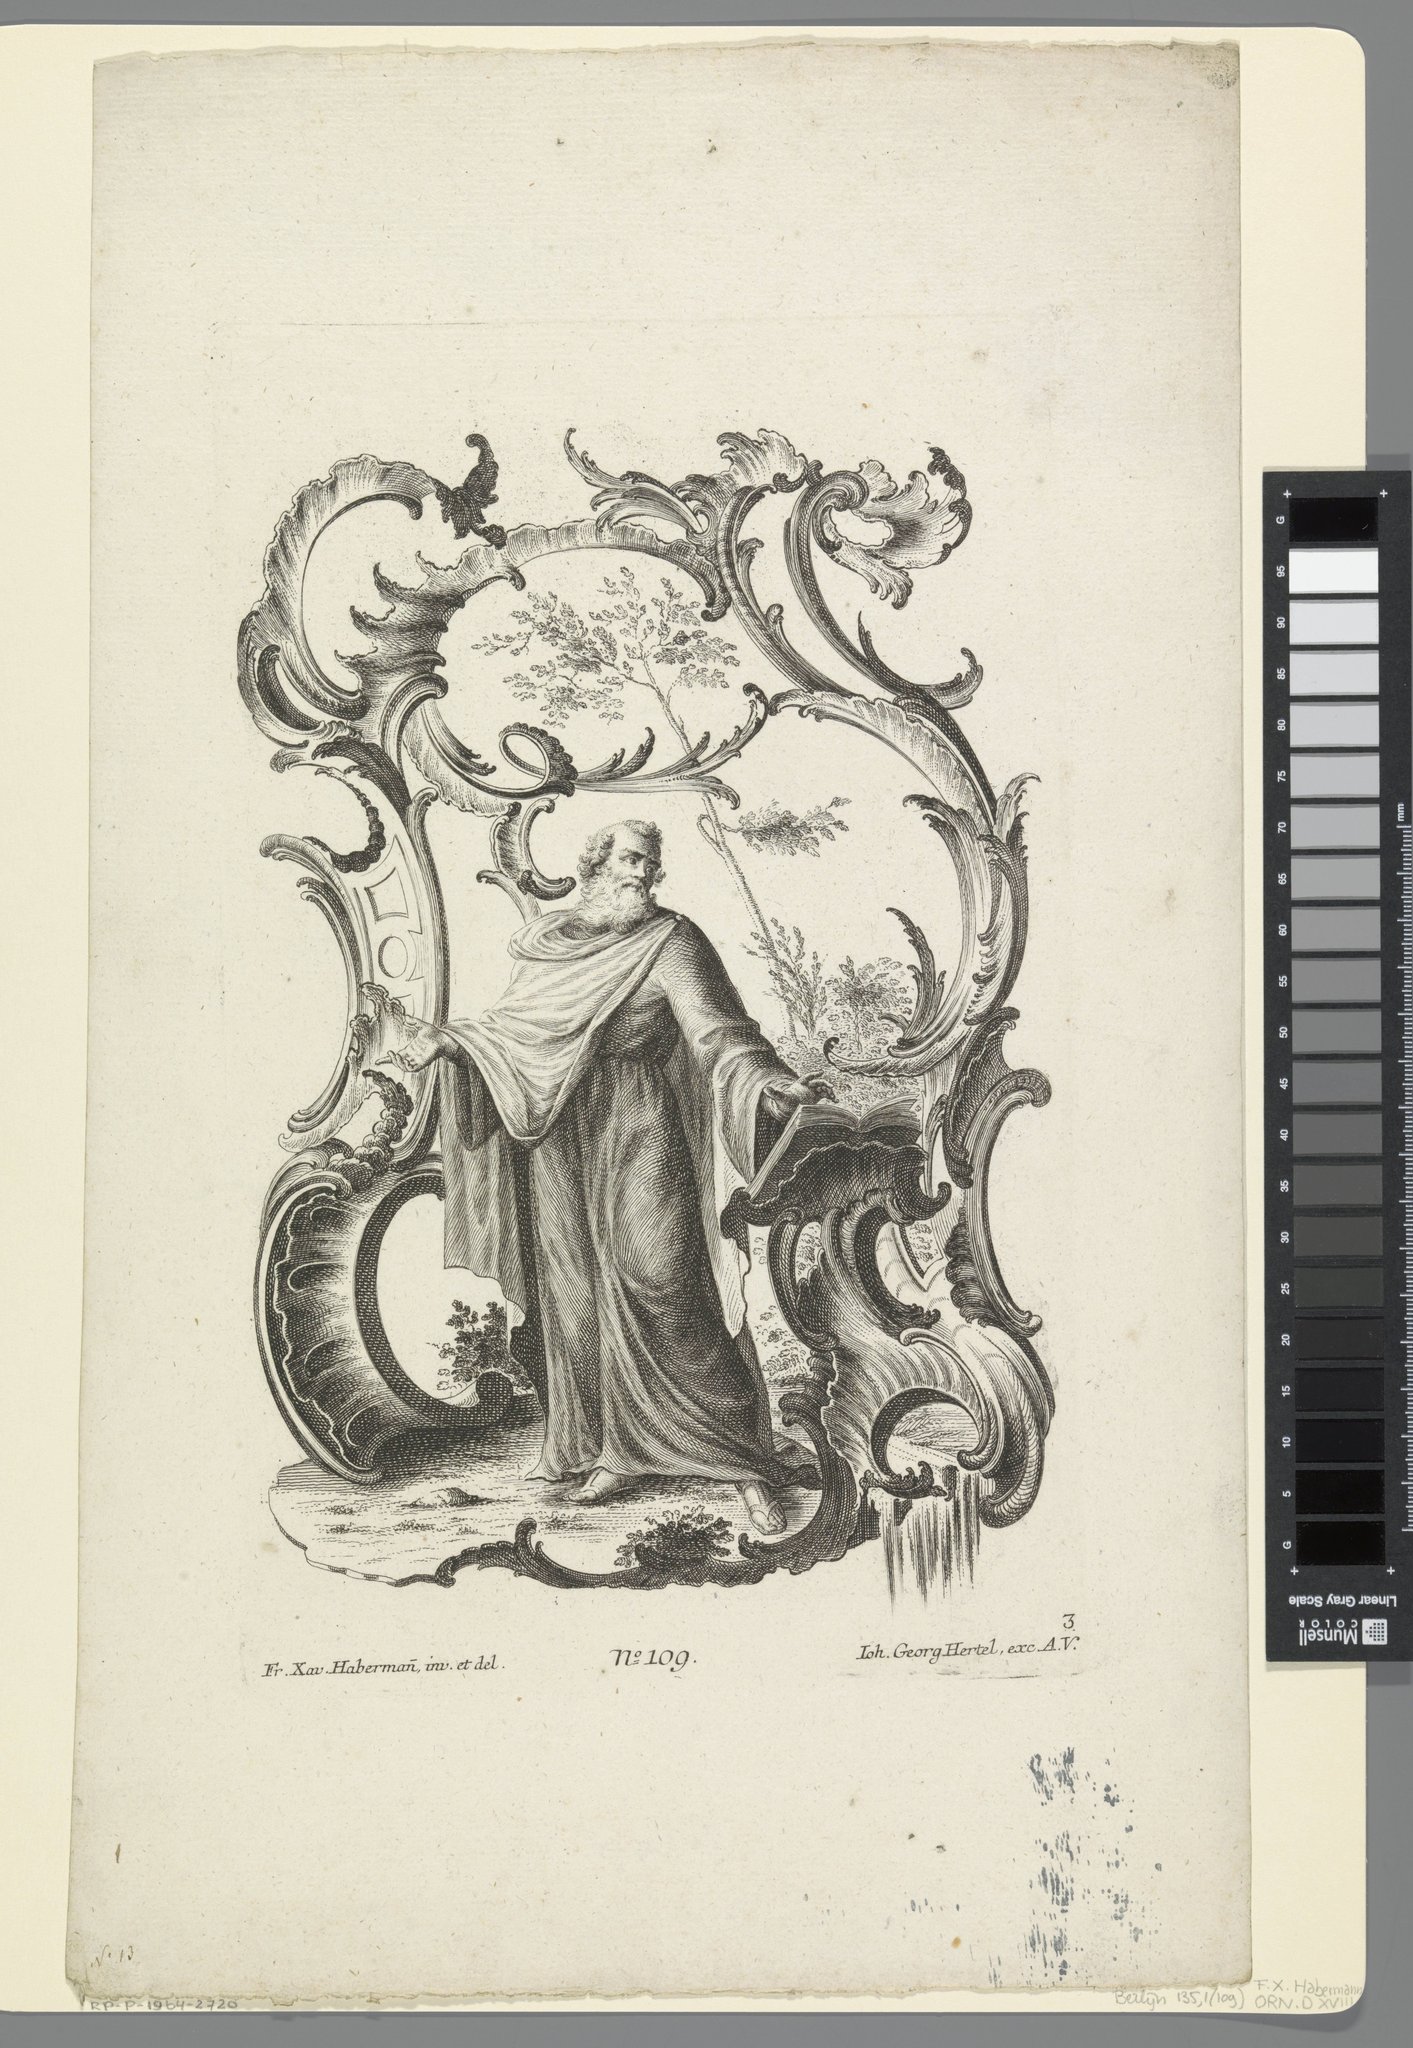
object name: print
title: Rocaille omraming met oude man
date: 1731-1775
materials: paper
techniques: etching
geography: augsburg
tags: rocaille ornament, old man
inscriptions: collector's mark: Lugt 2760, collector's mark: Lugt 2228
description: Rocaille omraming met oude man met cape en boek in landschap. Uitgeversnummer 109.